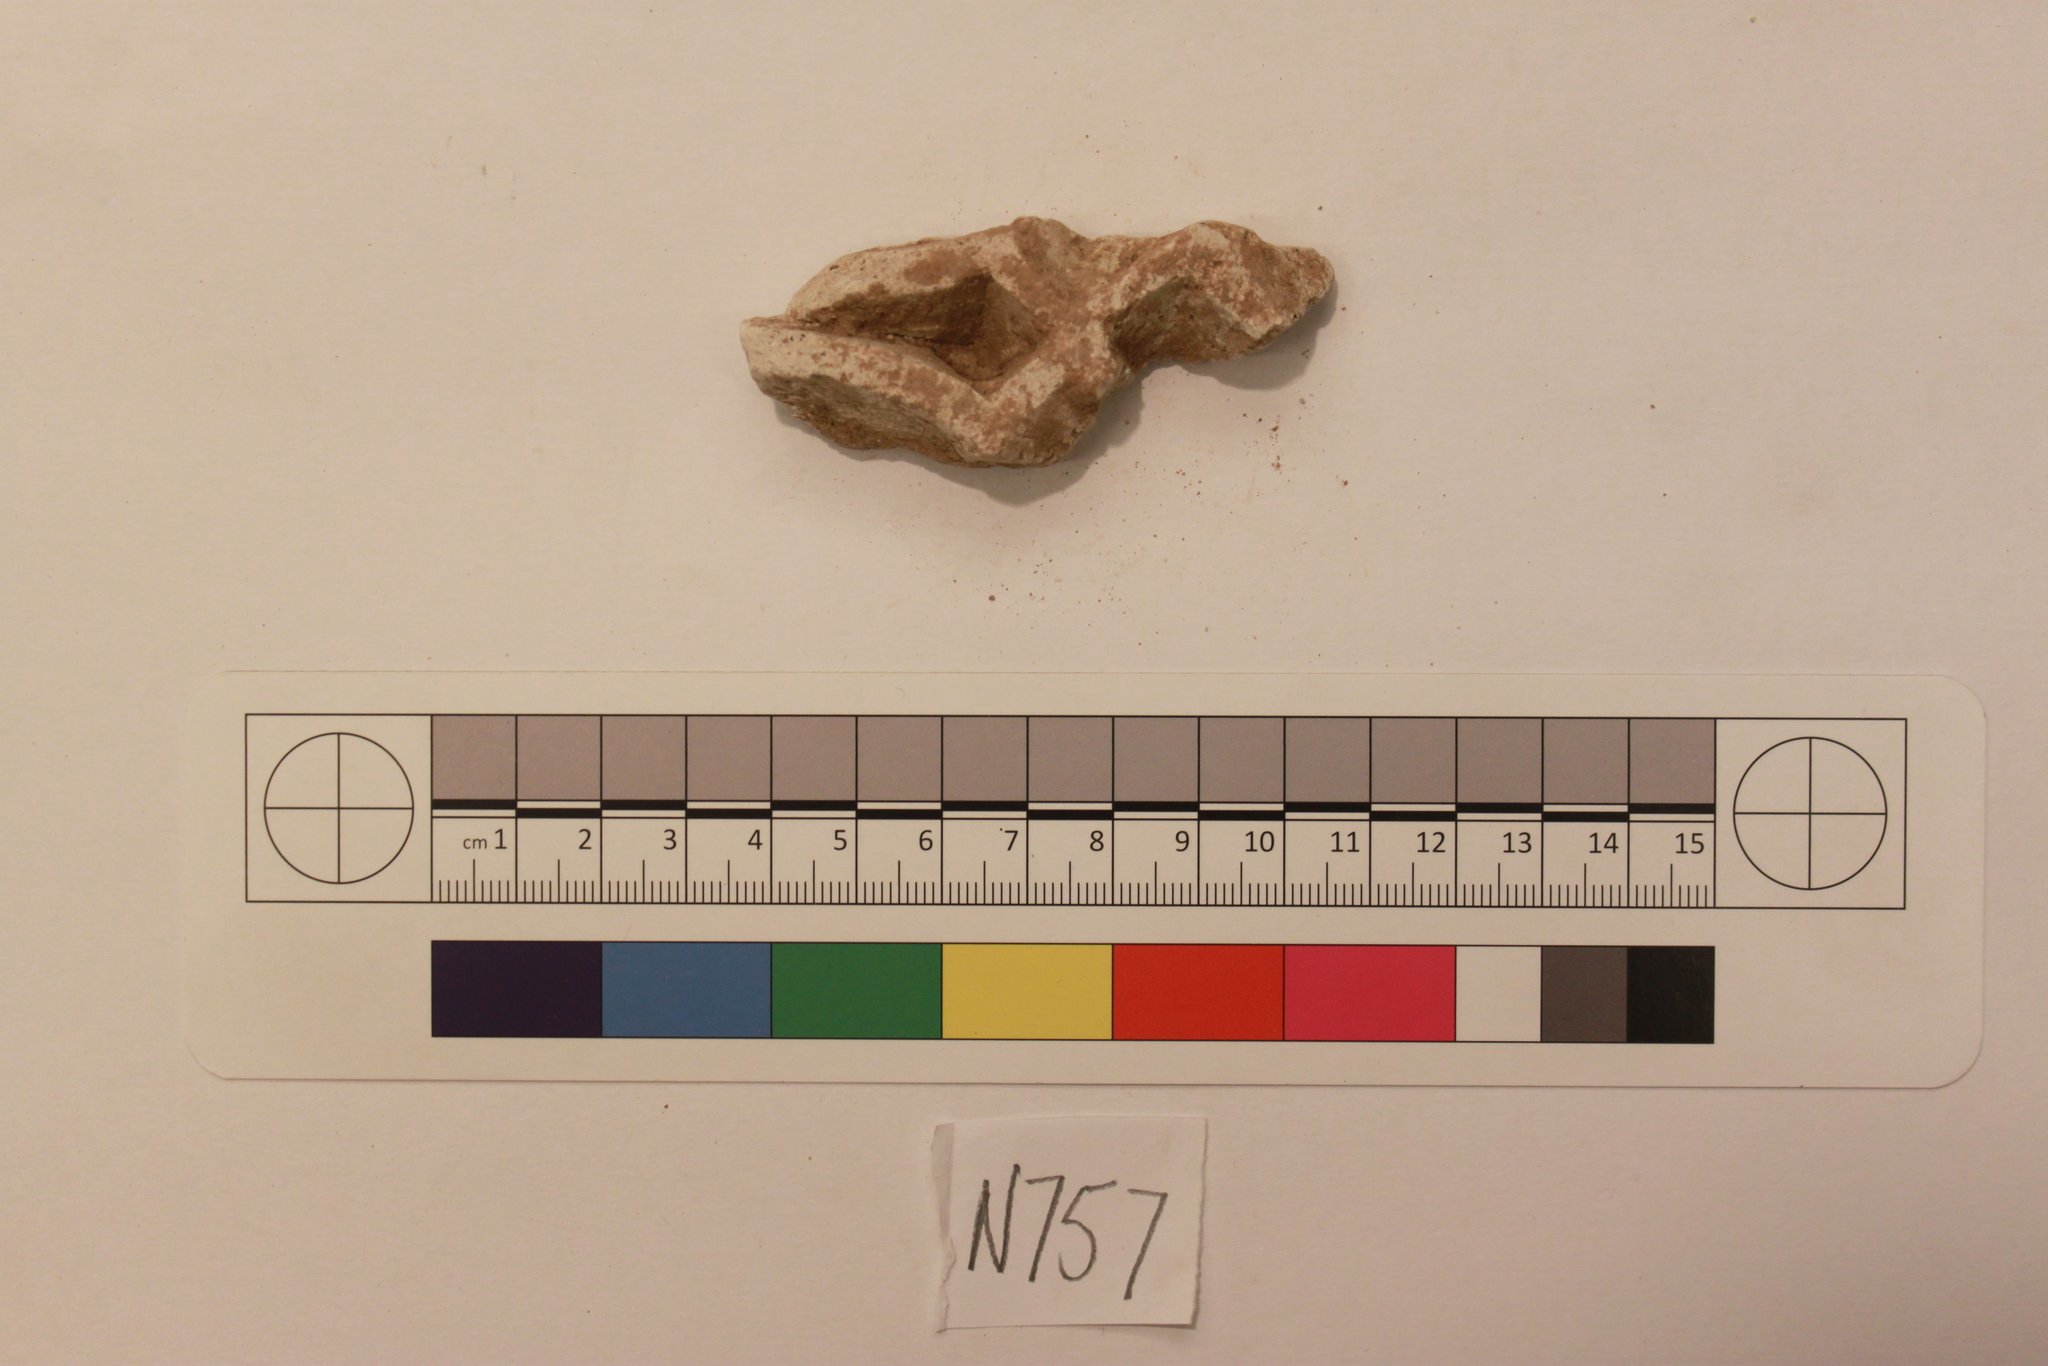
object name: fragment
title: Stucco Fragment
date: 701-1200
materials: plaster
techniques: carving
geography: iran